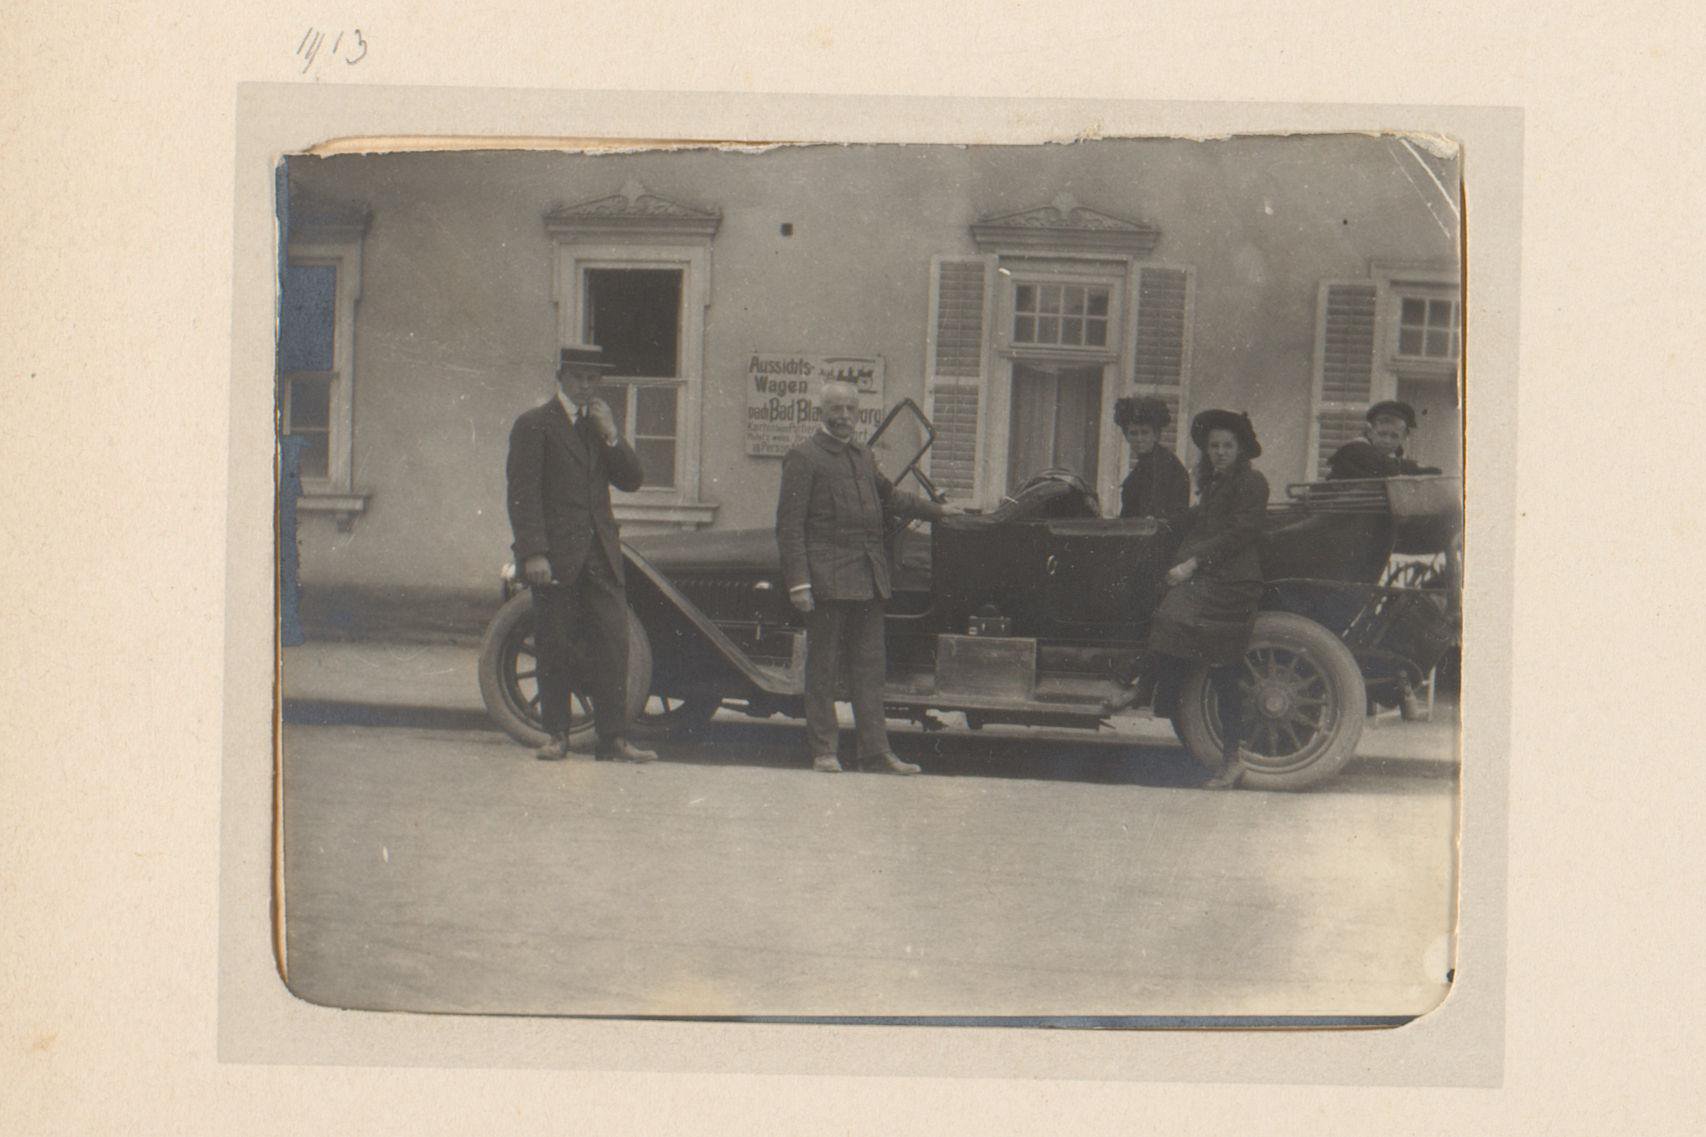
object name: photograph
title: Gezelschap bij een auto, mogelijk te Oberhof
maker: liesbeth overhoff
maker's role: fotograaf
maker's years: 1895-1969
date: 1913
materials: paper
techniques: gelatin silver print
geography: oberhof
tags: historical persons, automobile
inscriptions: inscription: ‘1913’